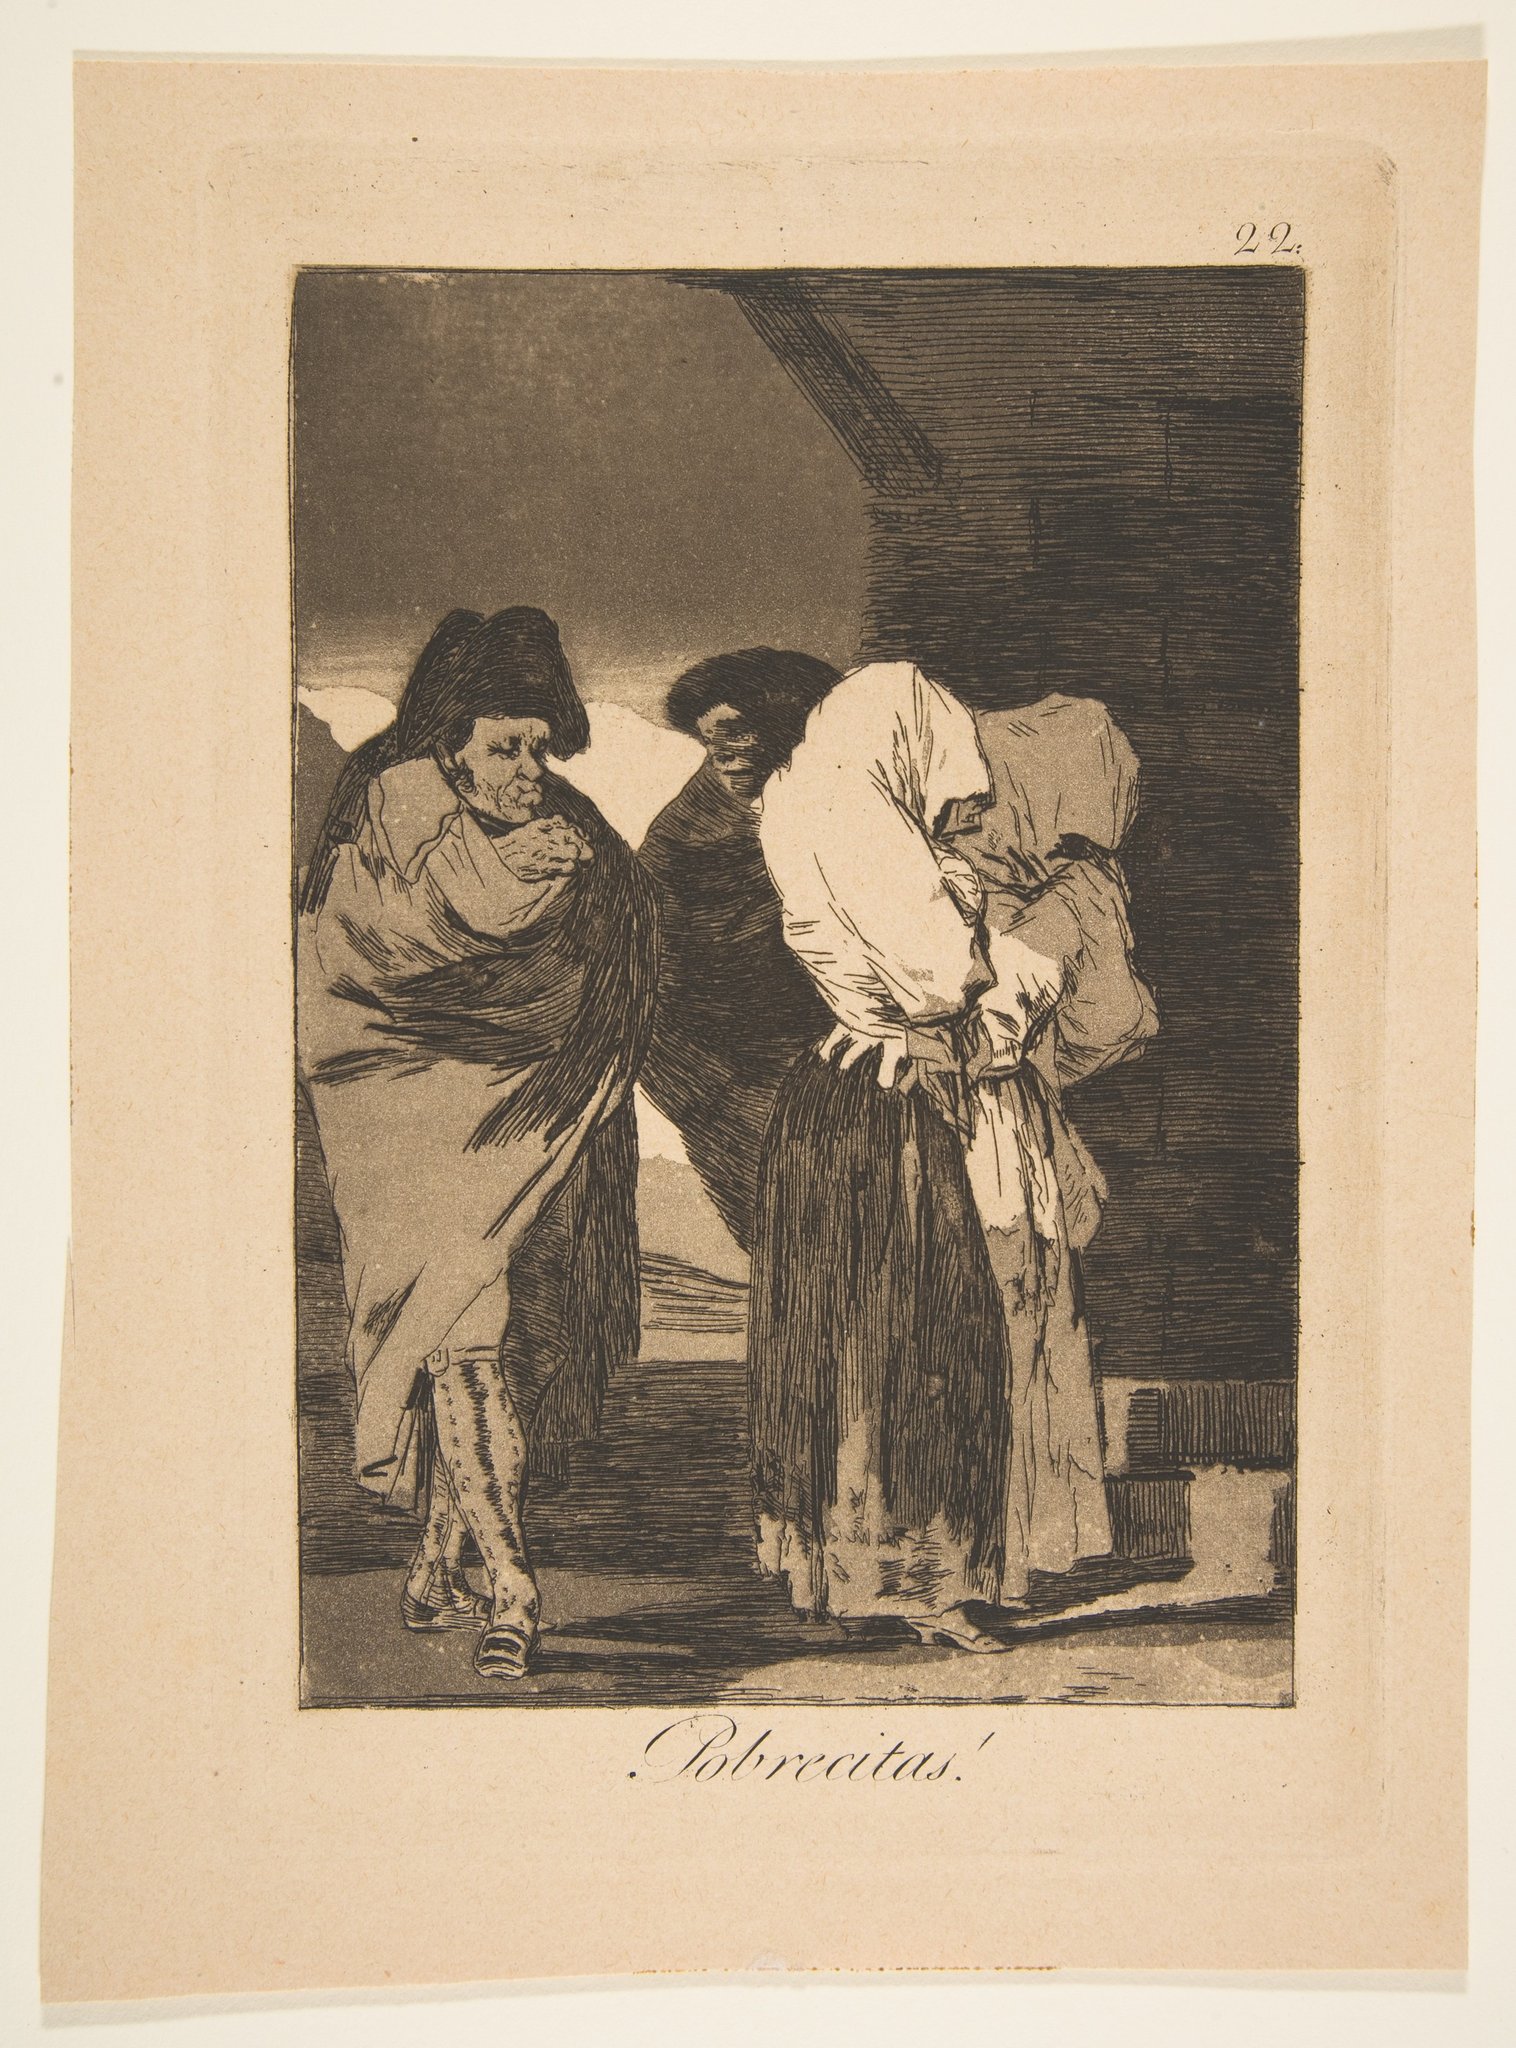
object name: print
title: Plate 22 from 'Los Caprichos': Poor little girls! (Probrecitas!)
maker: goya (francisco de goya y lucientes)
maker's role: artist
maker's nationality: spanish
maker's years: 1746-1828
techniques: aquatint, burnishing, etching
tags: girls